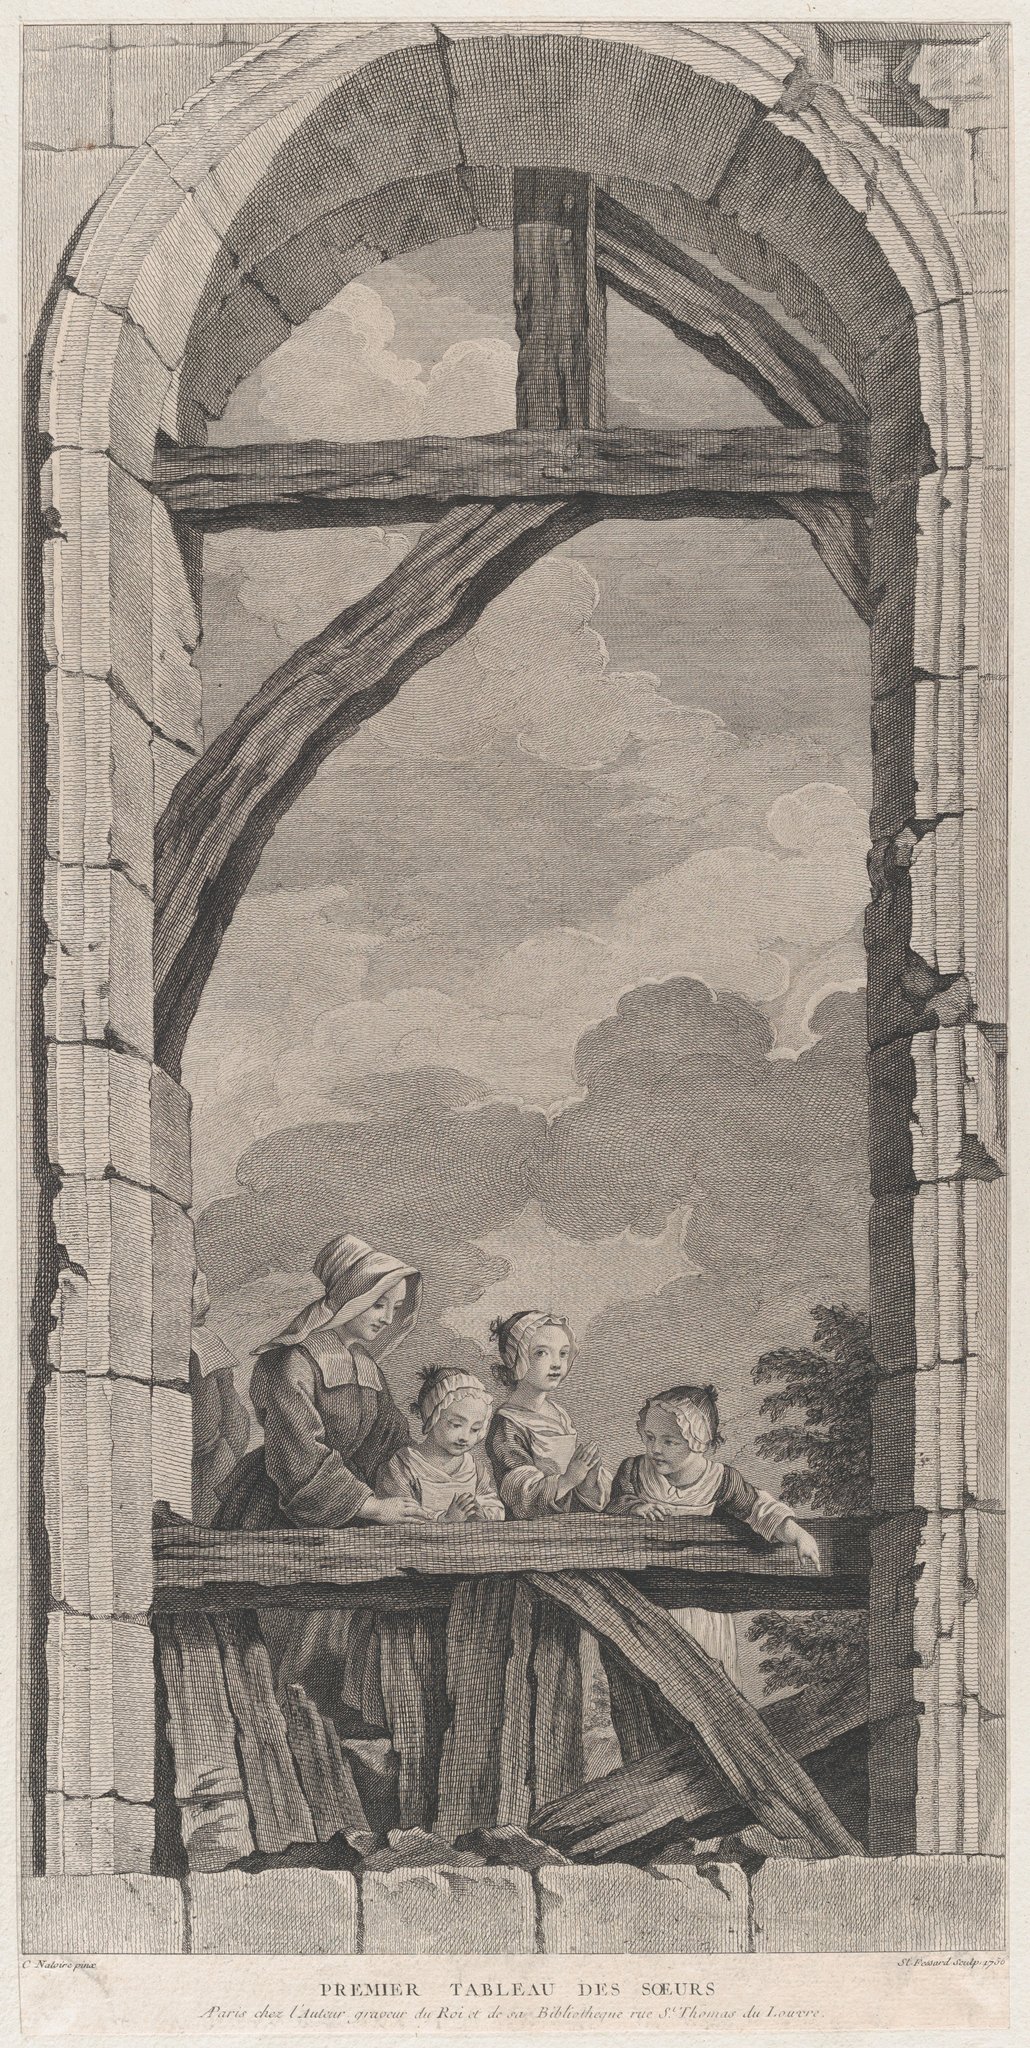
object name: print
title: The Chapel of the Enfants-Trouvés in Paris: Religieuse et petites filles regardant la crèche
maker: etienne fessard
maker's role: artist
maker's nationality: french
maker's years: 1714-1777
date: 1756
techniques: engraving, etching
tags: girls,women